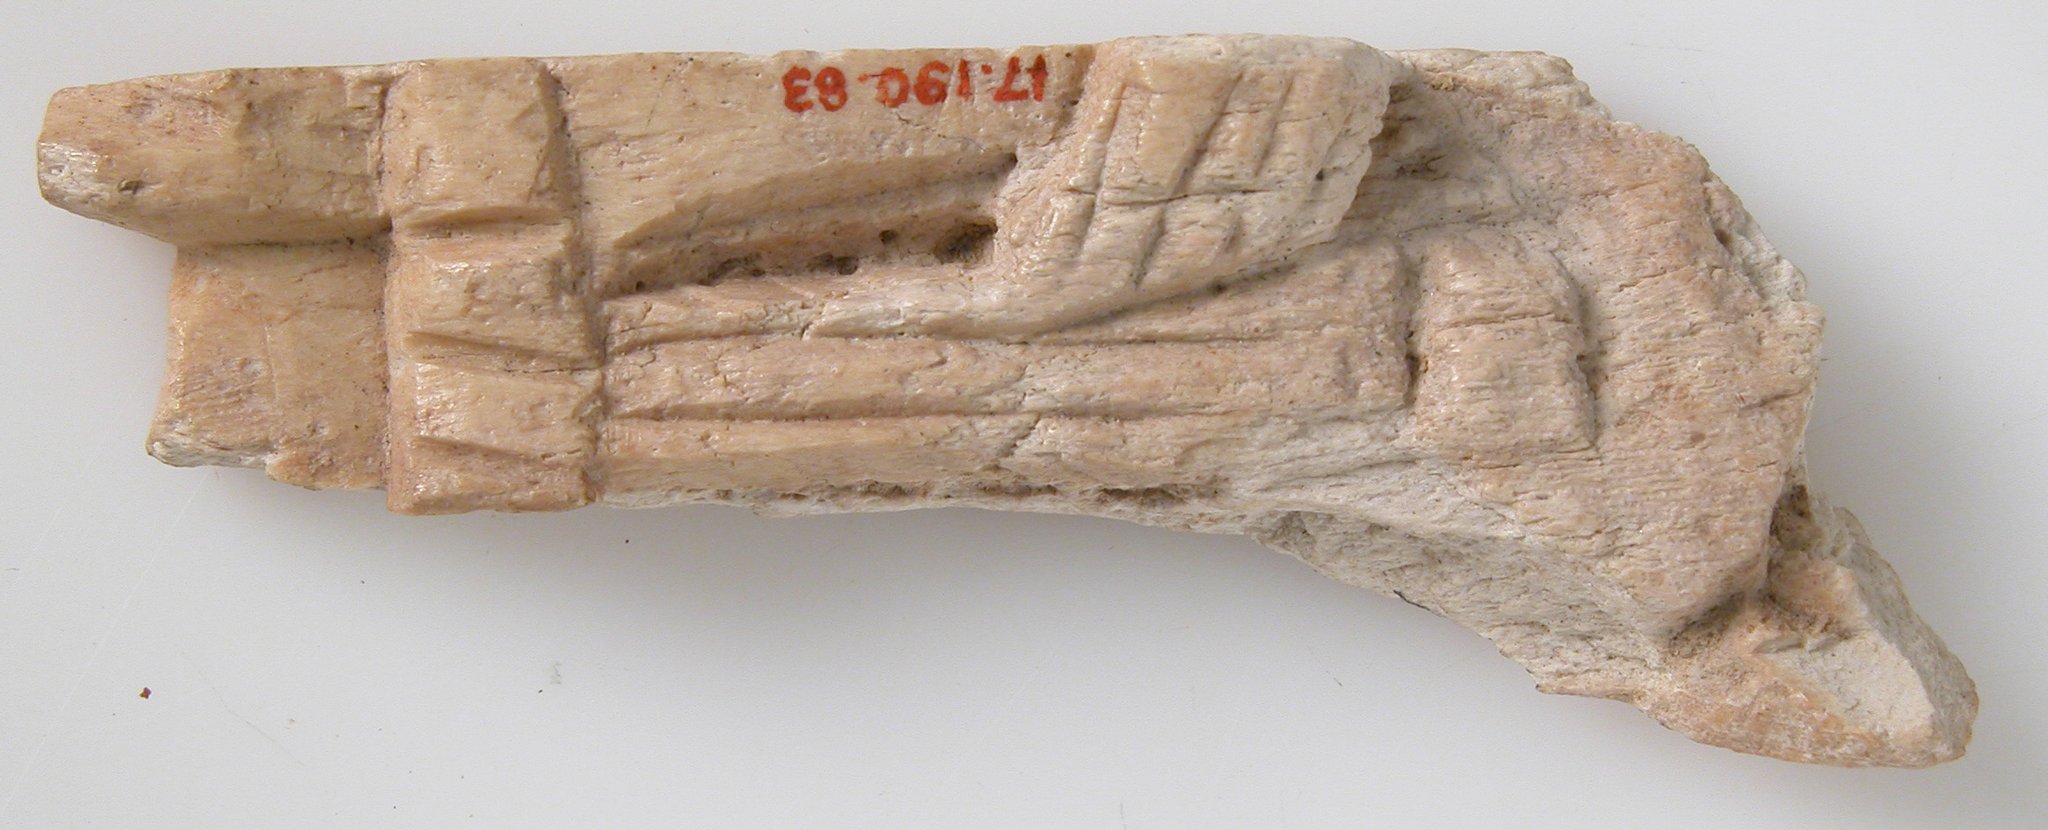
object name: fragment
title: Relief Fragment with Floral Design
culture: coptic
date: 501-700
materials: ivory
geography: egypt